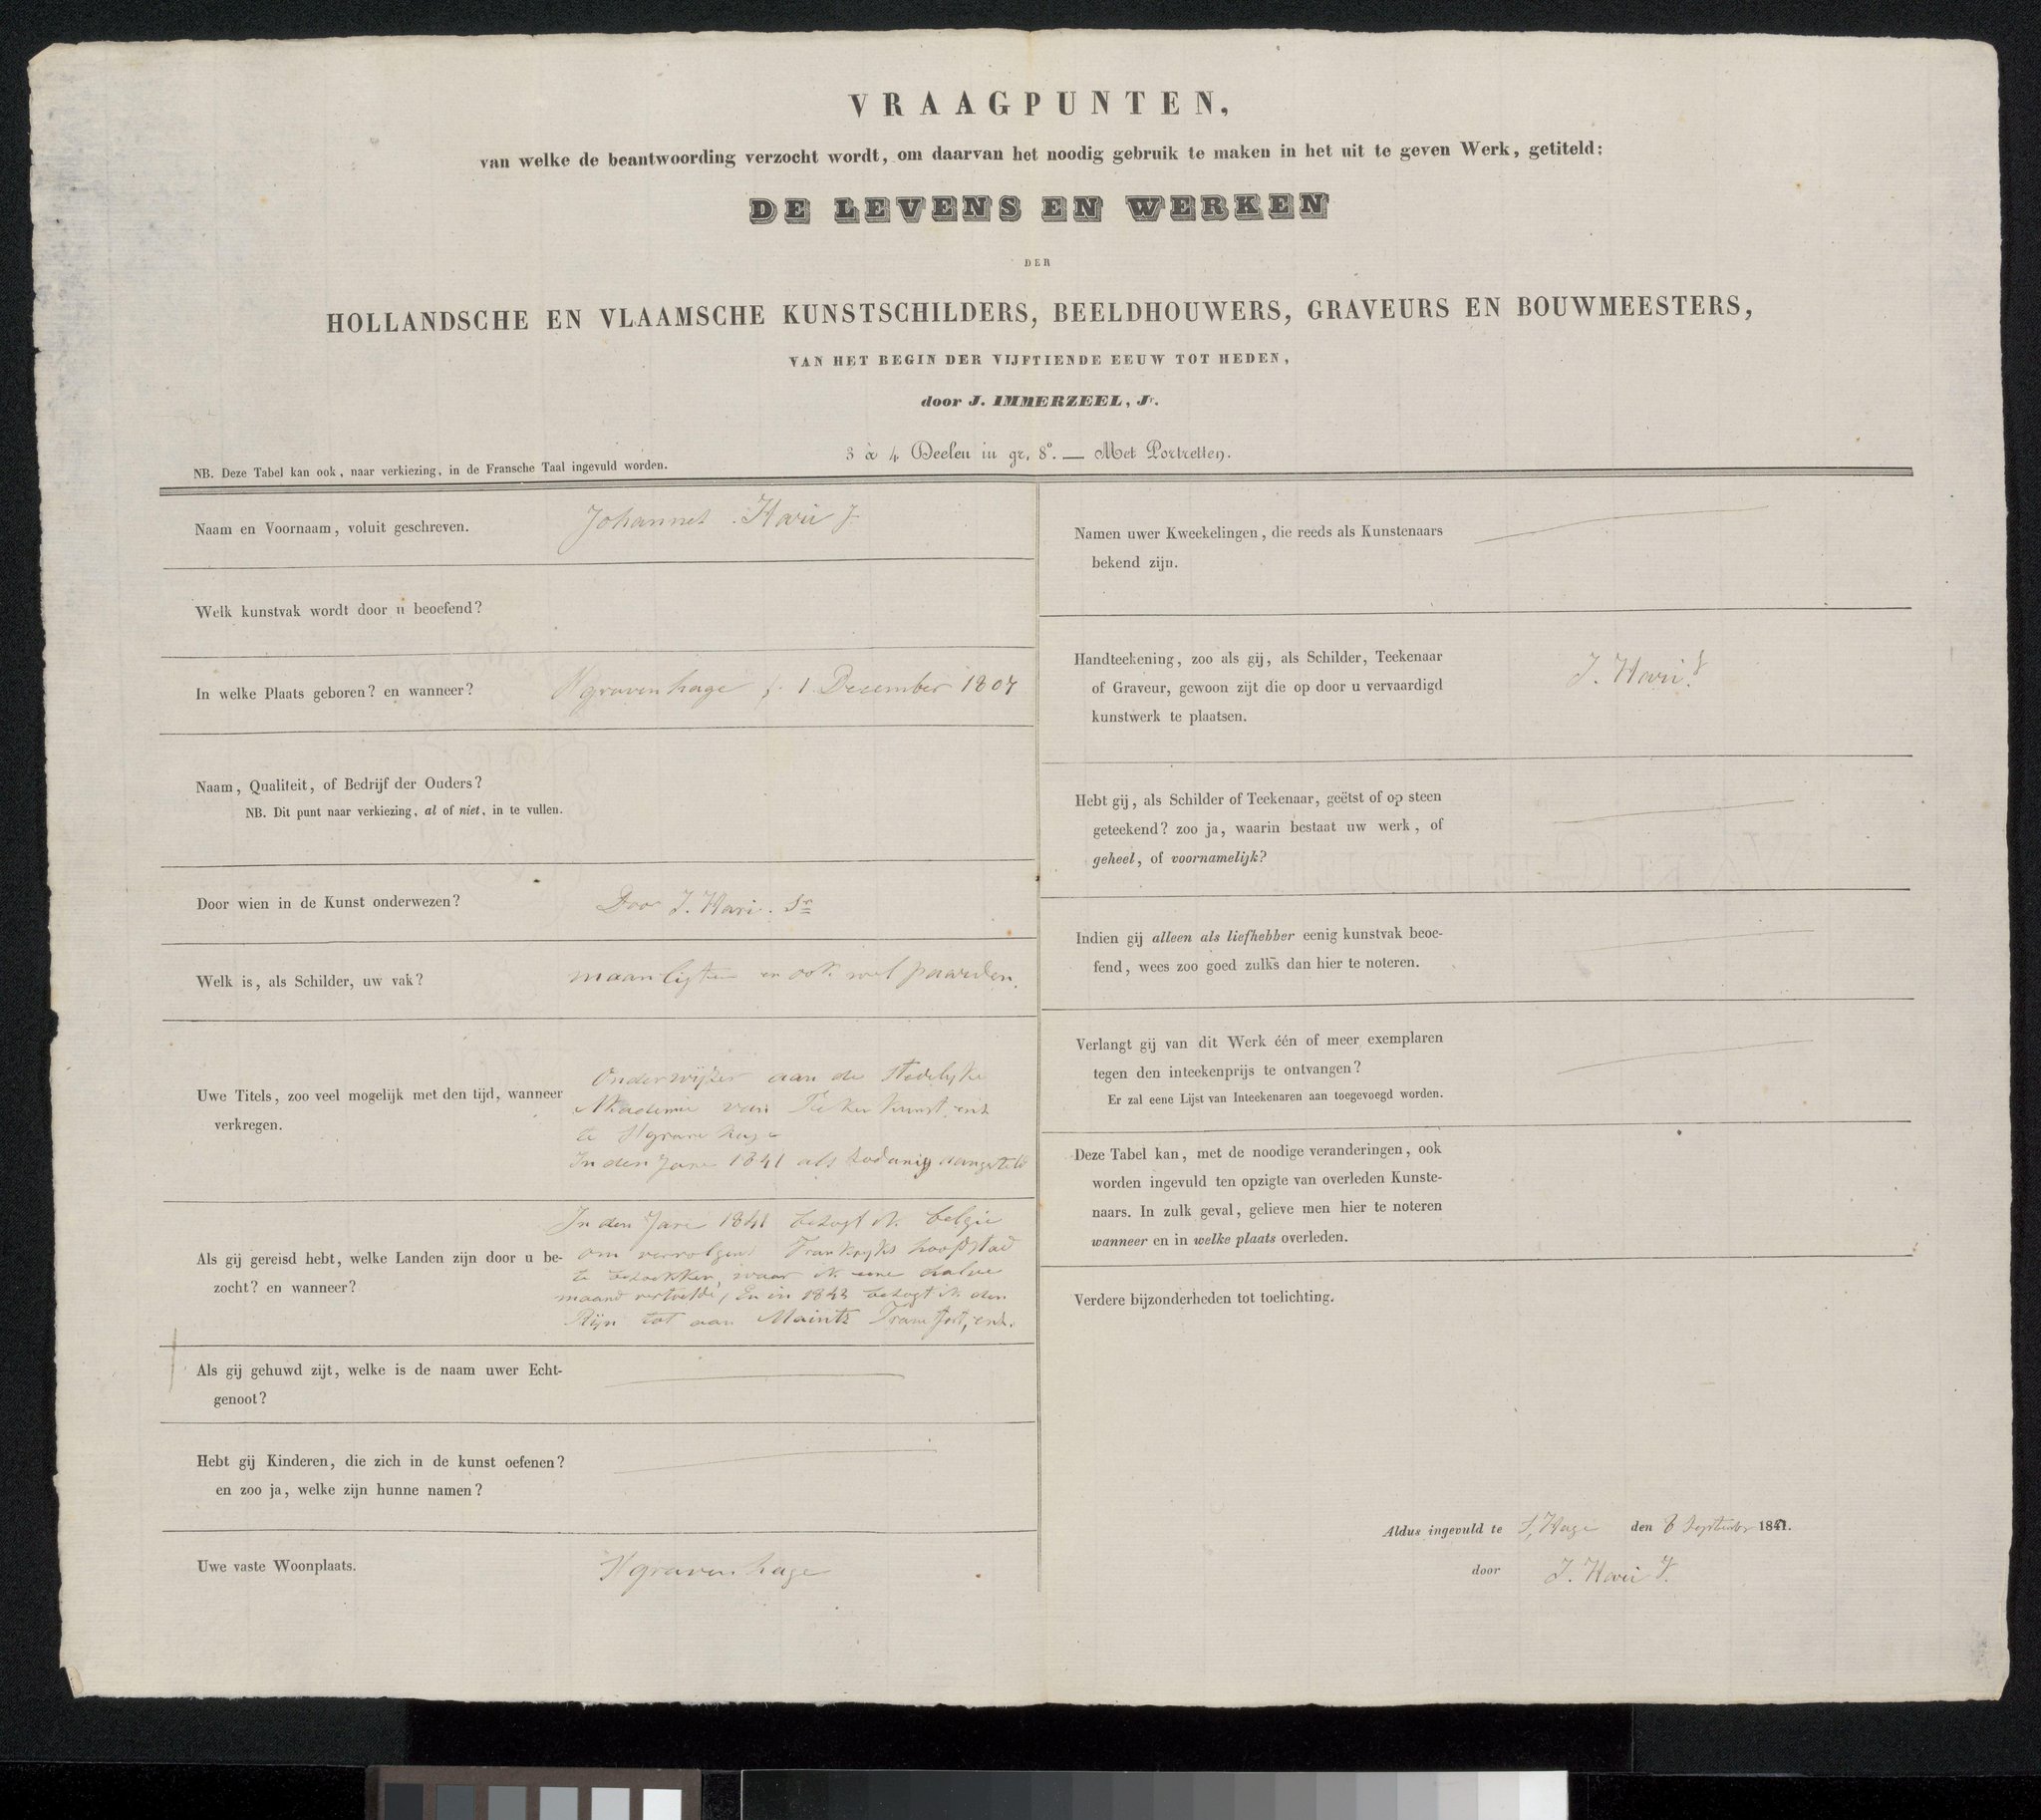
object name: questionnaire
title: Enquêteformulier ingevuld door Johannes Hari (II)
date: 1841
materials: ink, paper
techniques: pen, printing, writing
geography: the hague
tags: painter, johannes hari (ii)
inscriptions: watermark, inscription: ‘Vraagpunten,/ van welke de beantwoording verzocht wordt, om daarvan het noodig gebruik te maken in het uit te geven Werk, getiteld: De levens en werken/ der Hollandsche en Vlaamsche kunstschilders, beeldhouwers,/ graveurs en bouwmeesters, van het begin der vijftiende eeuw tot heden/ door J. Immerzeel, Jr.’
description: Opgenomen in: Immerzeel, J. Jr., De levens en werken der Hollandsche en Vlaamsche kunstschilders, beeldhouwers, graveurs en bouwmeesters, van het begin der vijftiende eeuw tot heden, Amsterdam: J.C. van Kesteren, 1842-1843.